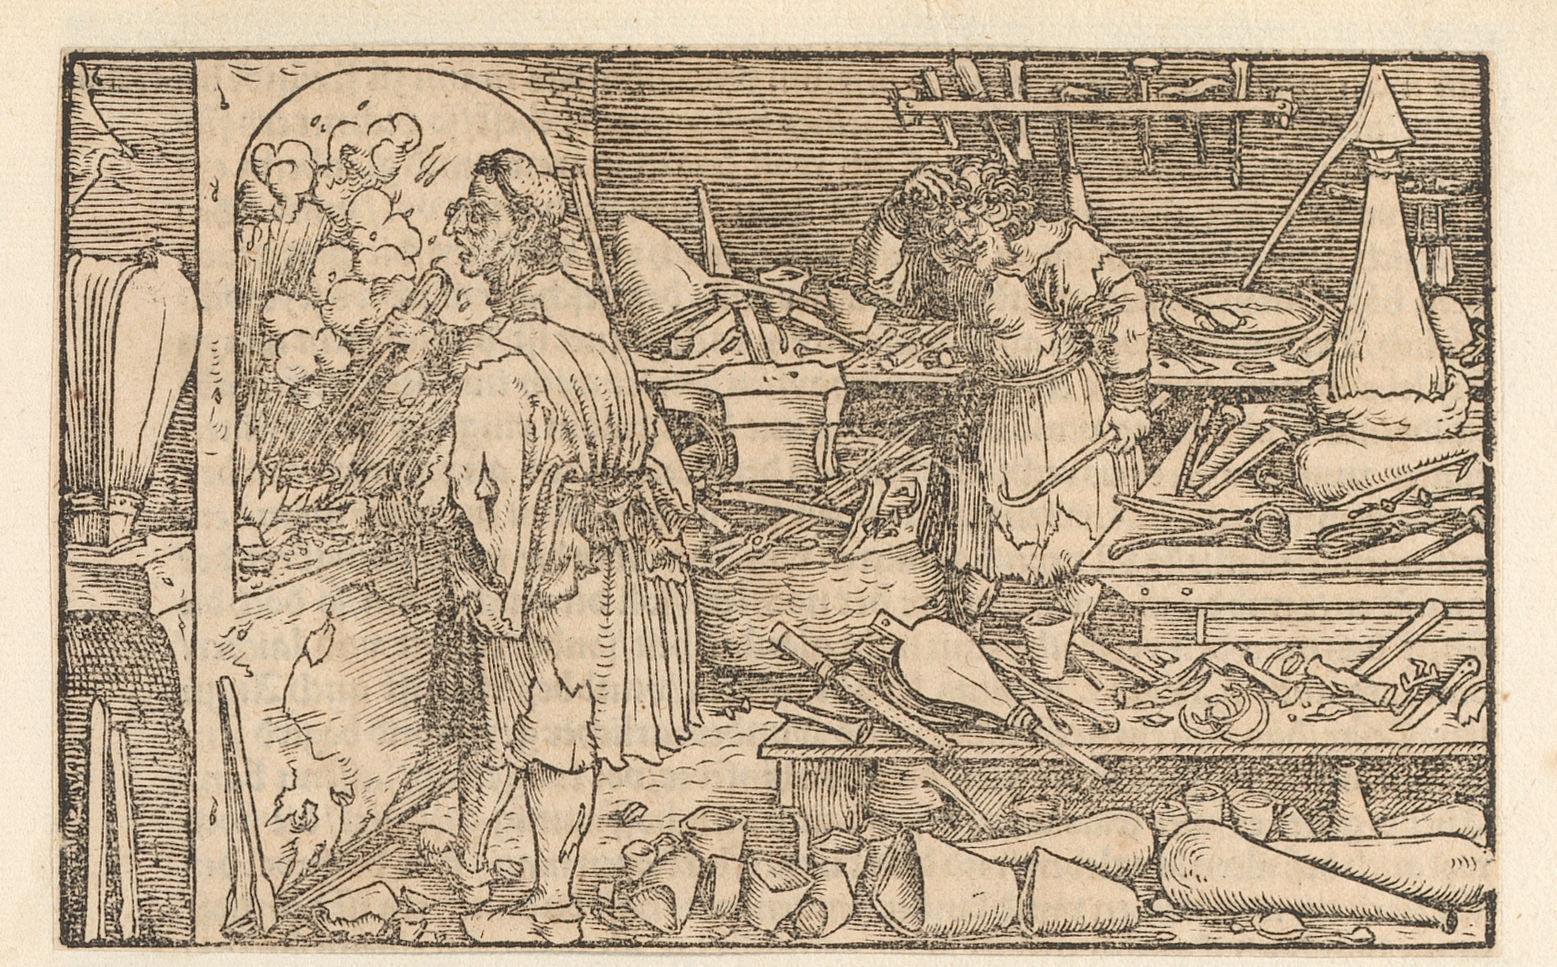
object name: album leaf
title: Twee alchemisten in hun werkplaats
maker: Anonymous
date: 1514-1532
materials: paper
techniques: letterpress printing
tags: alchemist at work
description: Deze prent is gebruikt in: Petrarca, Francesco. Von der Artzney bayder Glück, des guten und widerwertigen: unnd weß sich ain yeder inn Gelück und Unglück halten sol (...). Augsburg: Heinrich Steiner, 1532. Deze uitgave is ook bekend onder de titel 'Trostspiegel in Glück und Unglück'.